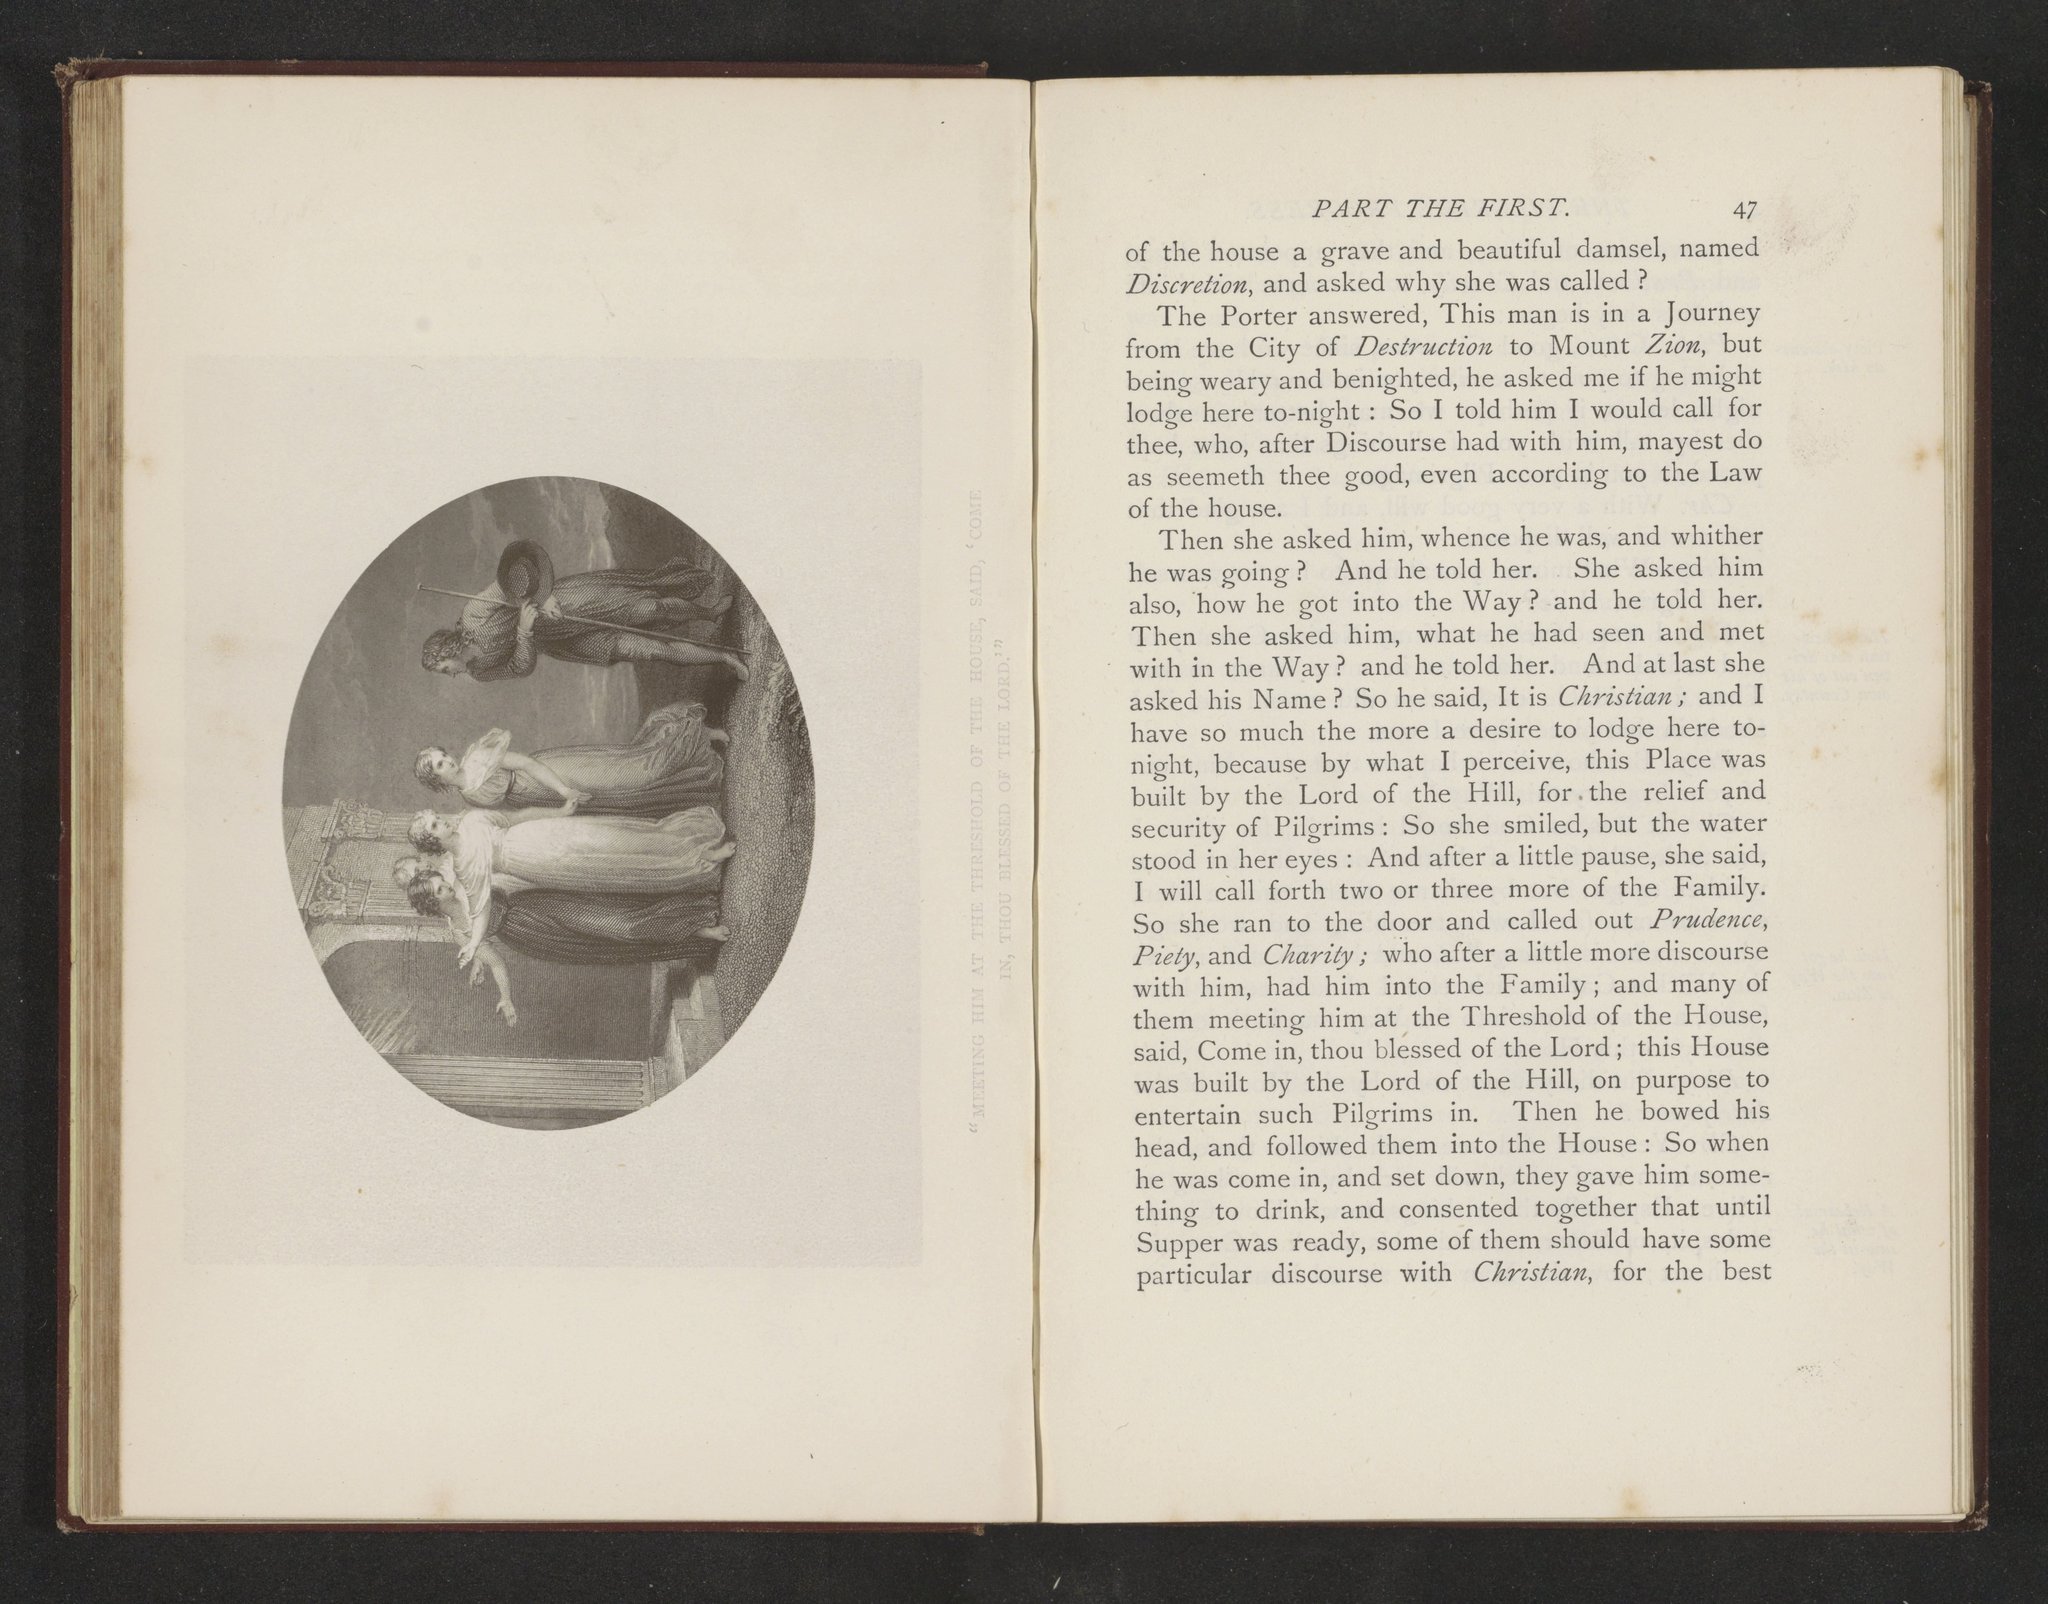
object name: reproduction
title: “Meeting Him at the Treshold of the House, said 'Come in, thou blessed of the Lord.'”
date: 1871-1881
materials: paper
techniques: woodburytype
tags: print, e.g.: engraving, etching, lithograph, angels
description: Illustratie betreft Christen voor de enge poort met vier vrouwen ervoor.